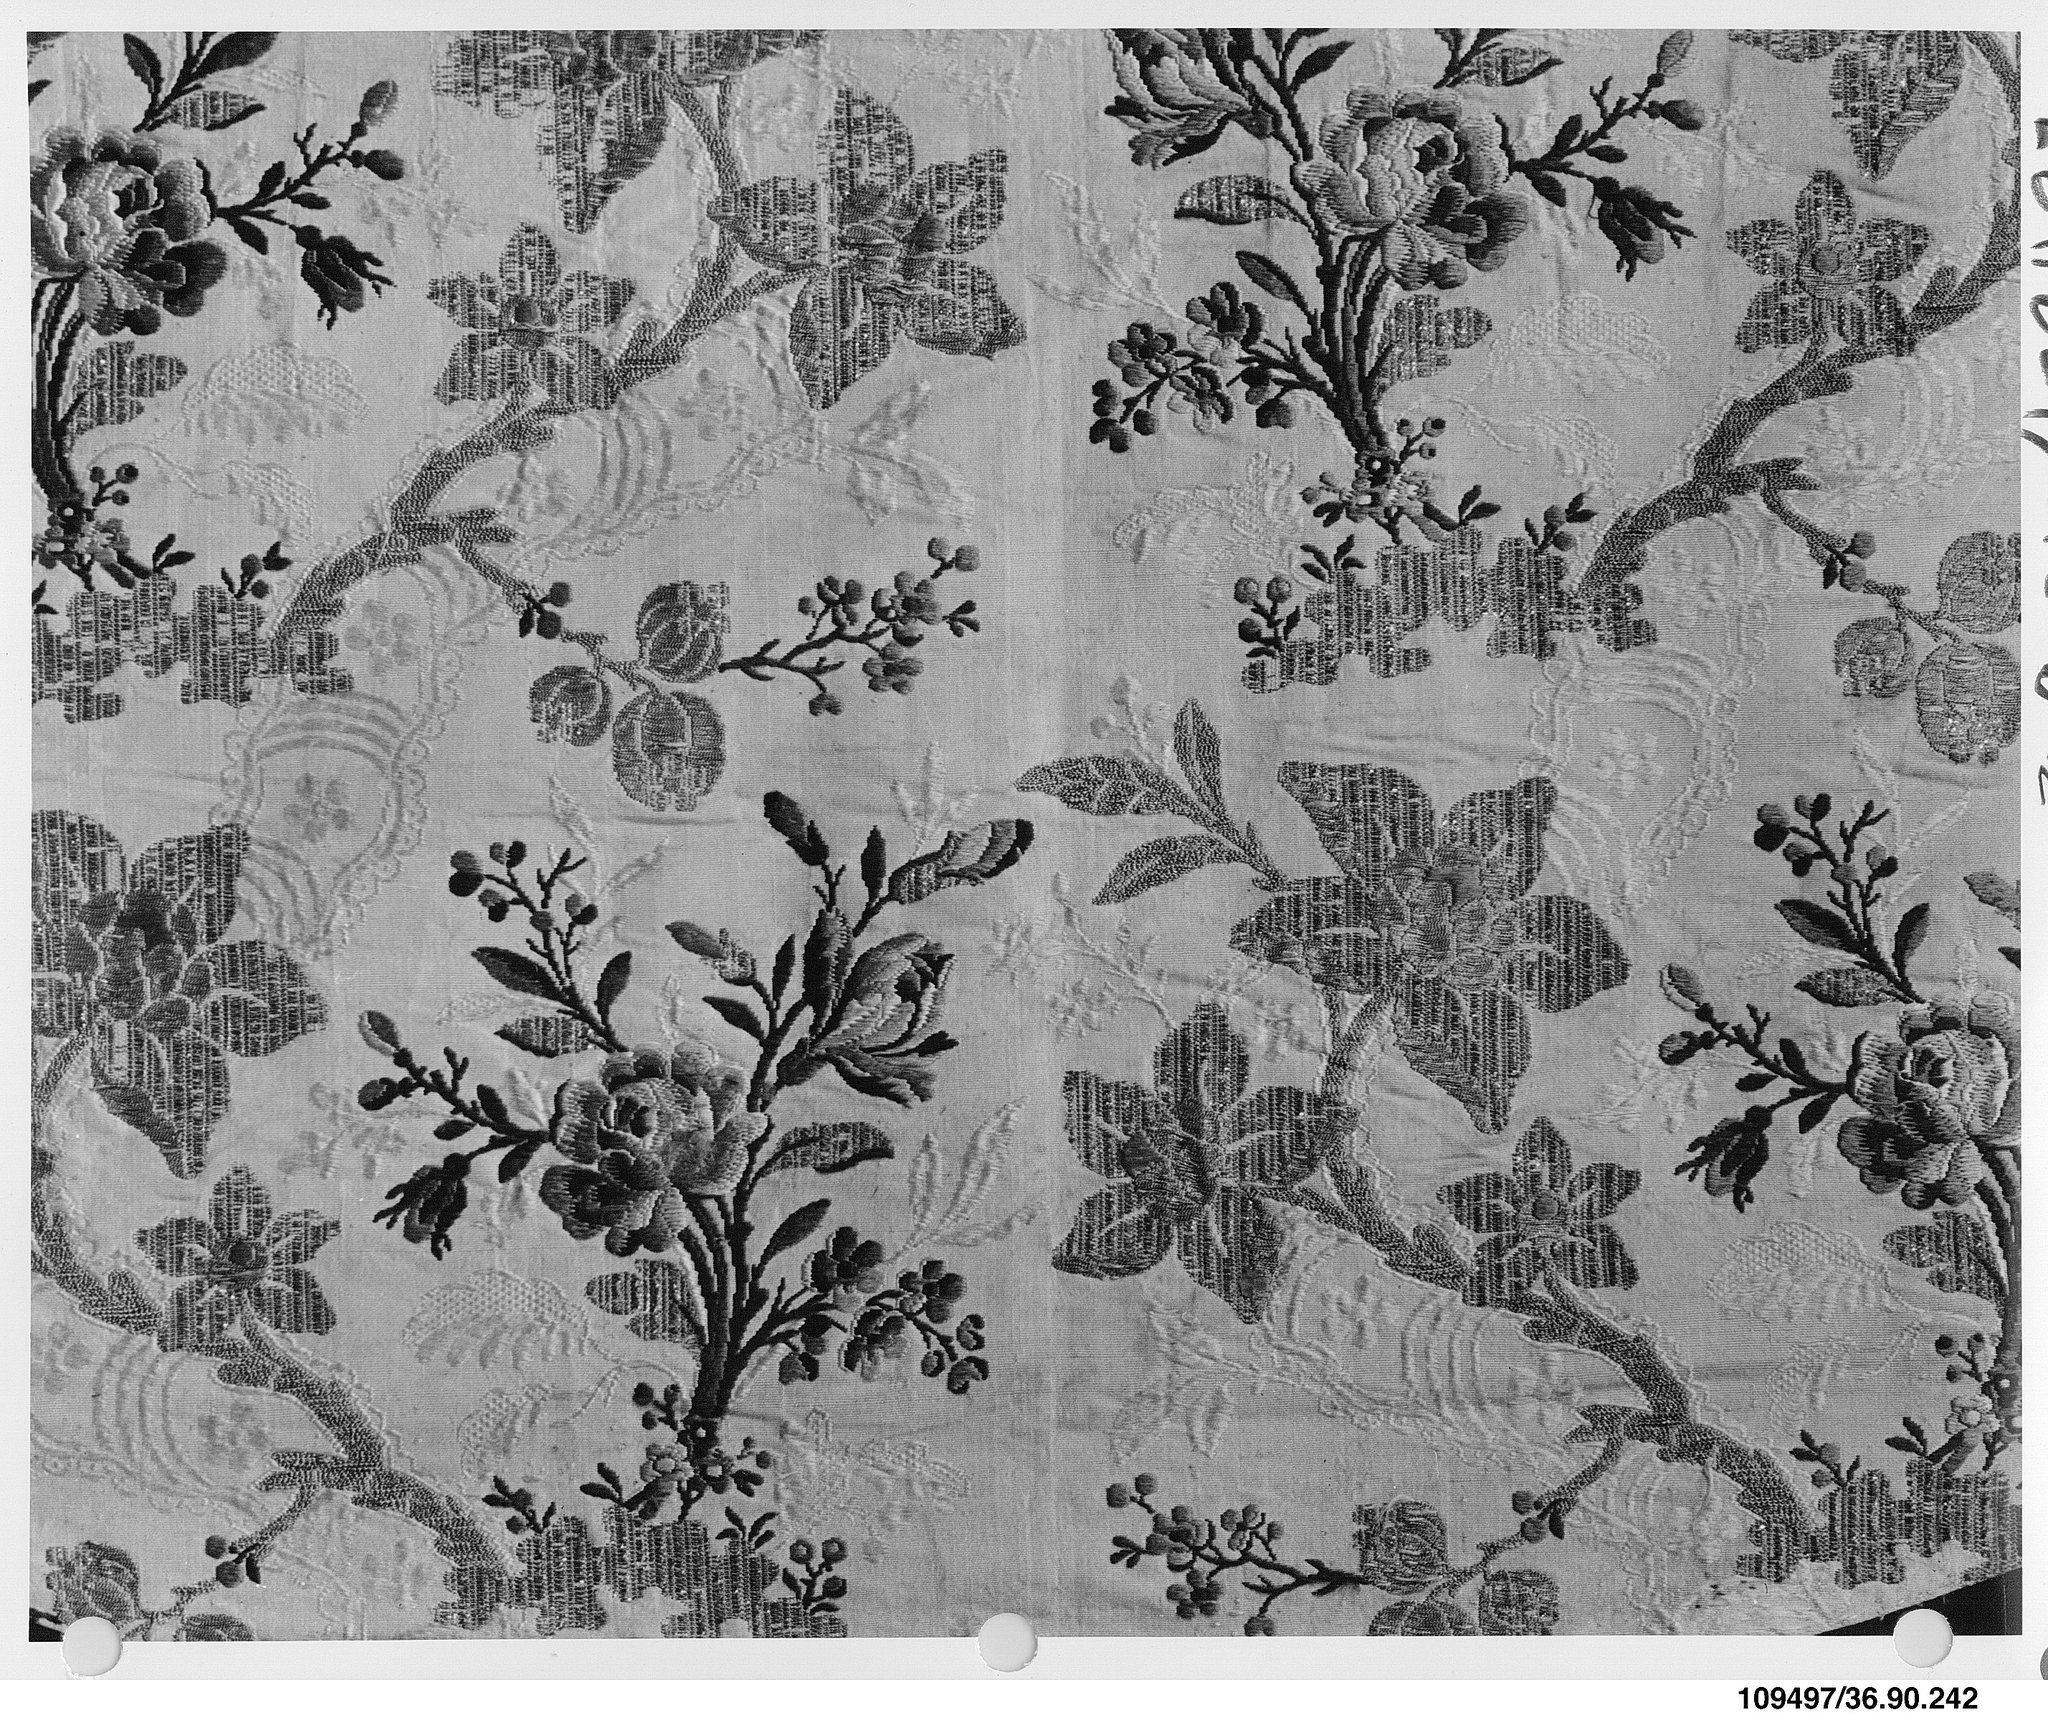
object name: piece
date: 1750-1760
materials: metal thread, silk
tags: flowers